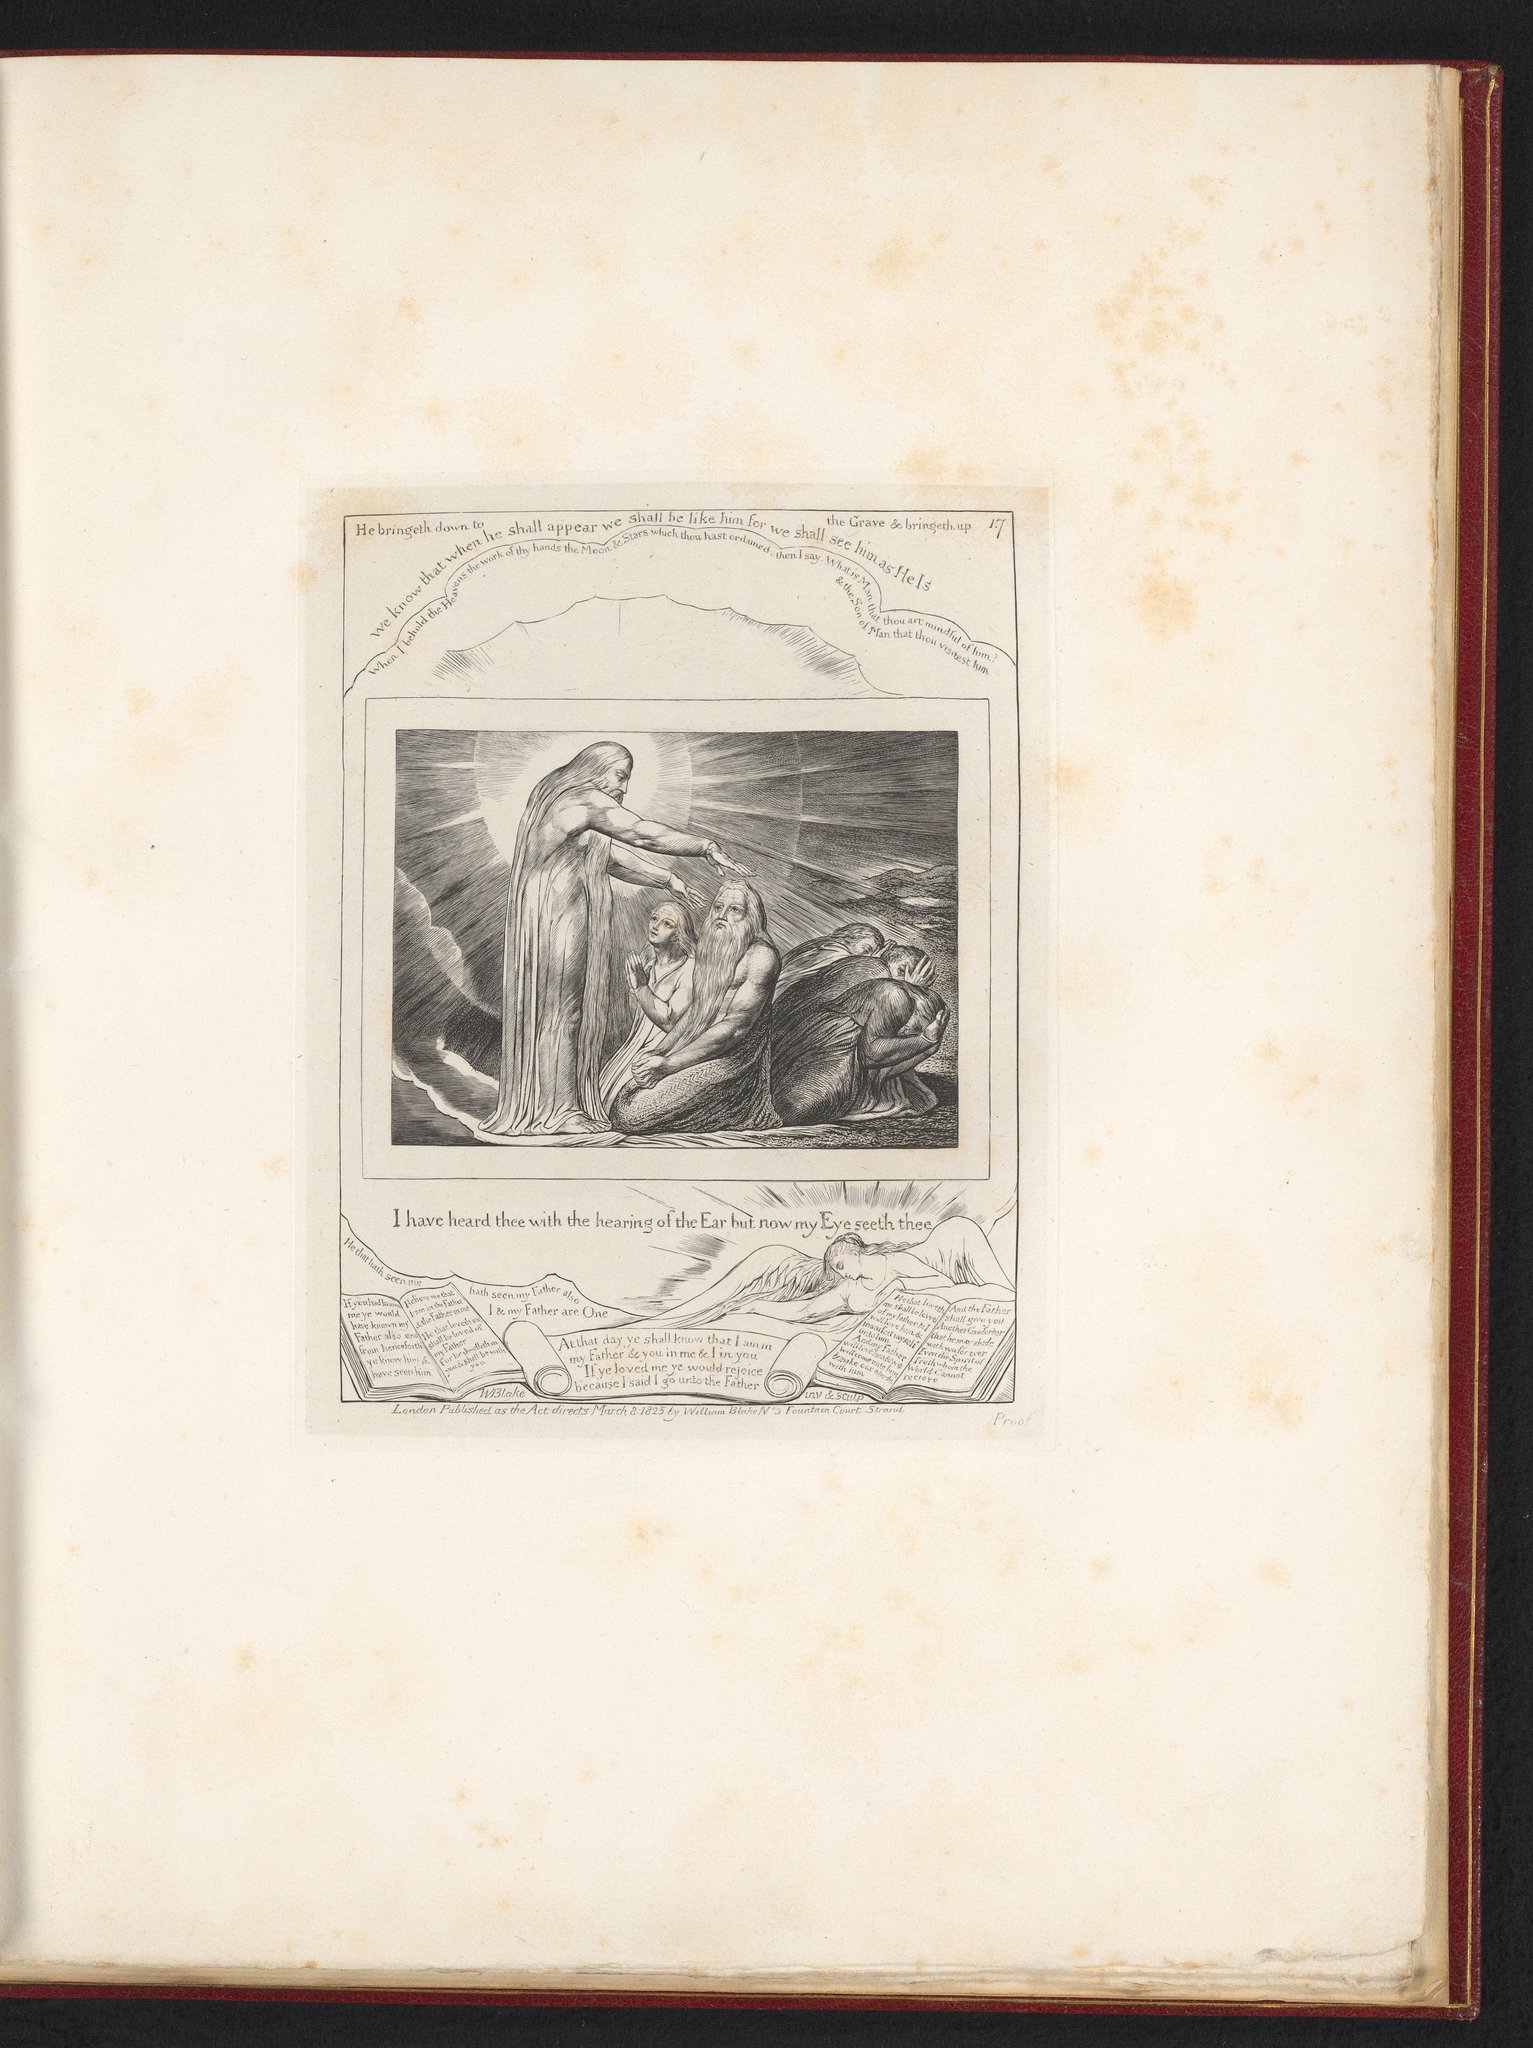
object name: print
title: I have heard thee with the hearing of the Ear but now my Eye seeth thee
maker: william blake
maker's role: print maker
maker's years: 1757-1827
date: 1825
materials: paper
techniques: engraving, etching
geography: london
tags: job's prosperity restored; the last part of his life (job 42:10-17)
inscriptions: collector's mark: Lugt 2228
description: Prent maakt deel uit van een serie van 21 prenten. Er bestaan 150 afdrukken van de serie met daarop 'proof'.